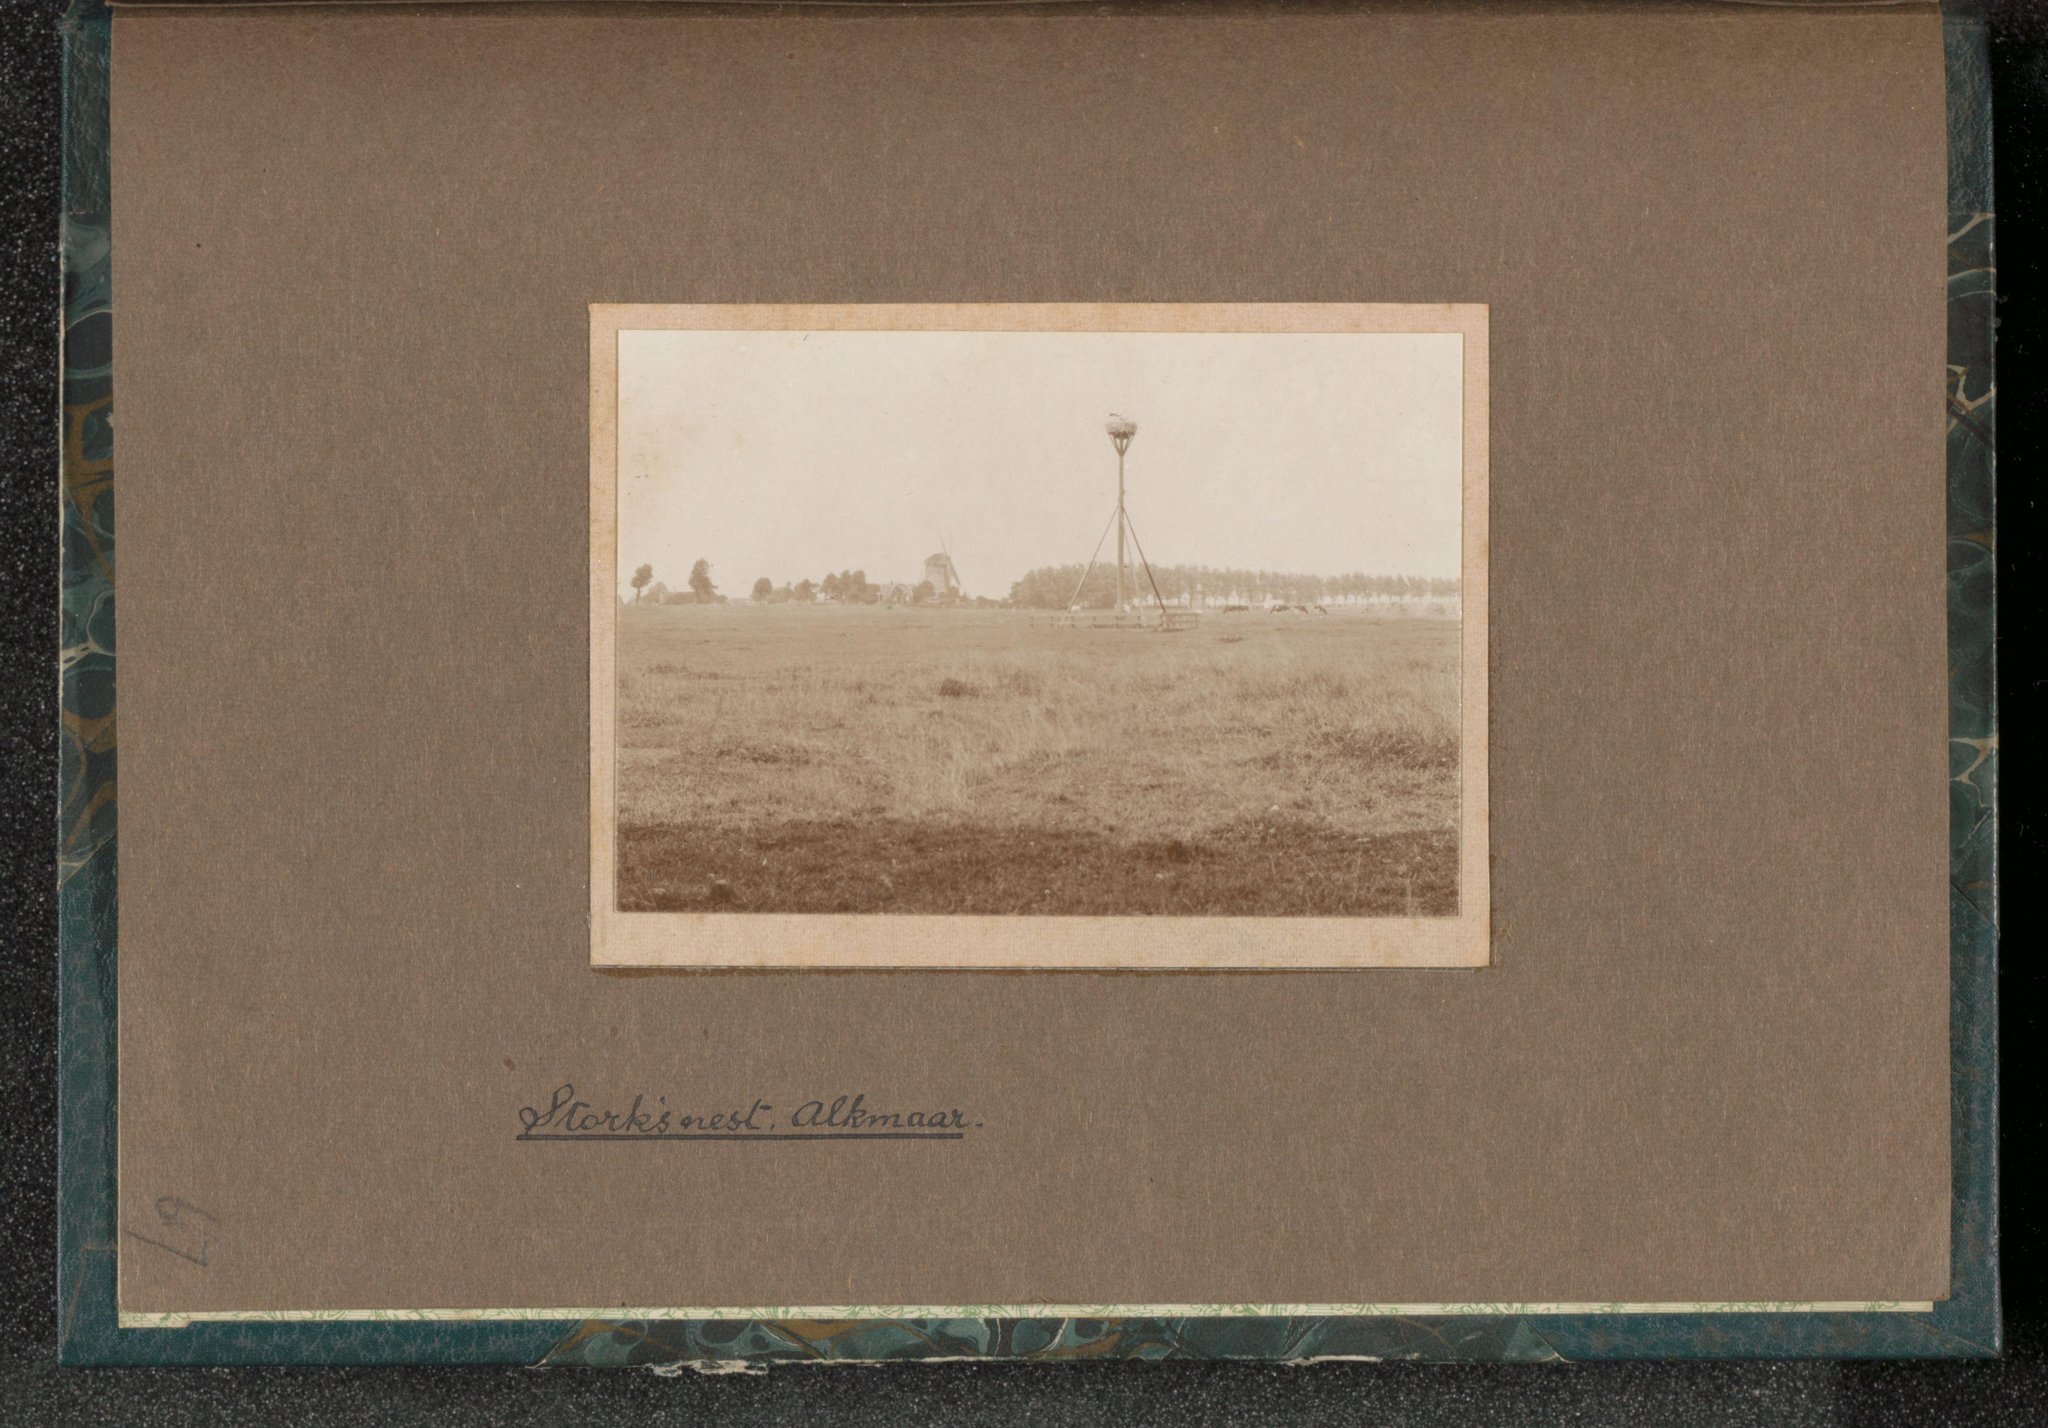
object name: photograph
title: Stork's nest Alkmaar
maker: Anonymous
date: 1912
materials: photographic support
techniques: gelatin silver print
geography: alkmaar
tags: shore-birds and wading-birds: stork, windmill in landscape, travelling; tourism, meadow, pasture (+ landscape with figures, staffage)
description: Onderdeel van Fotoalbum van de excursie naar Nederland van de Britse amateurfotografenvereniging P.C.U.K.